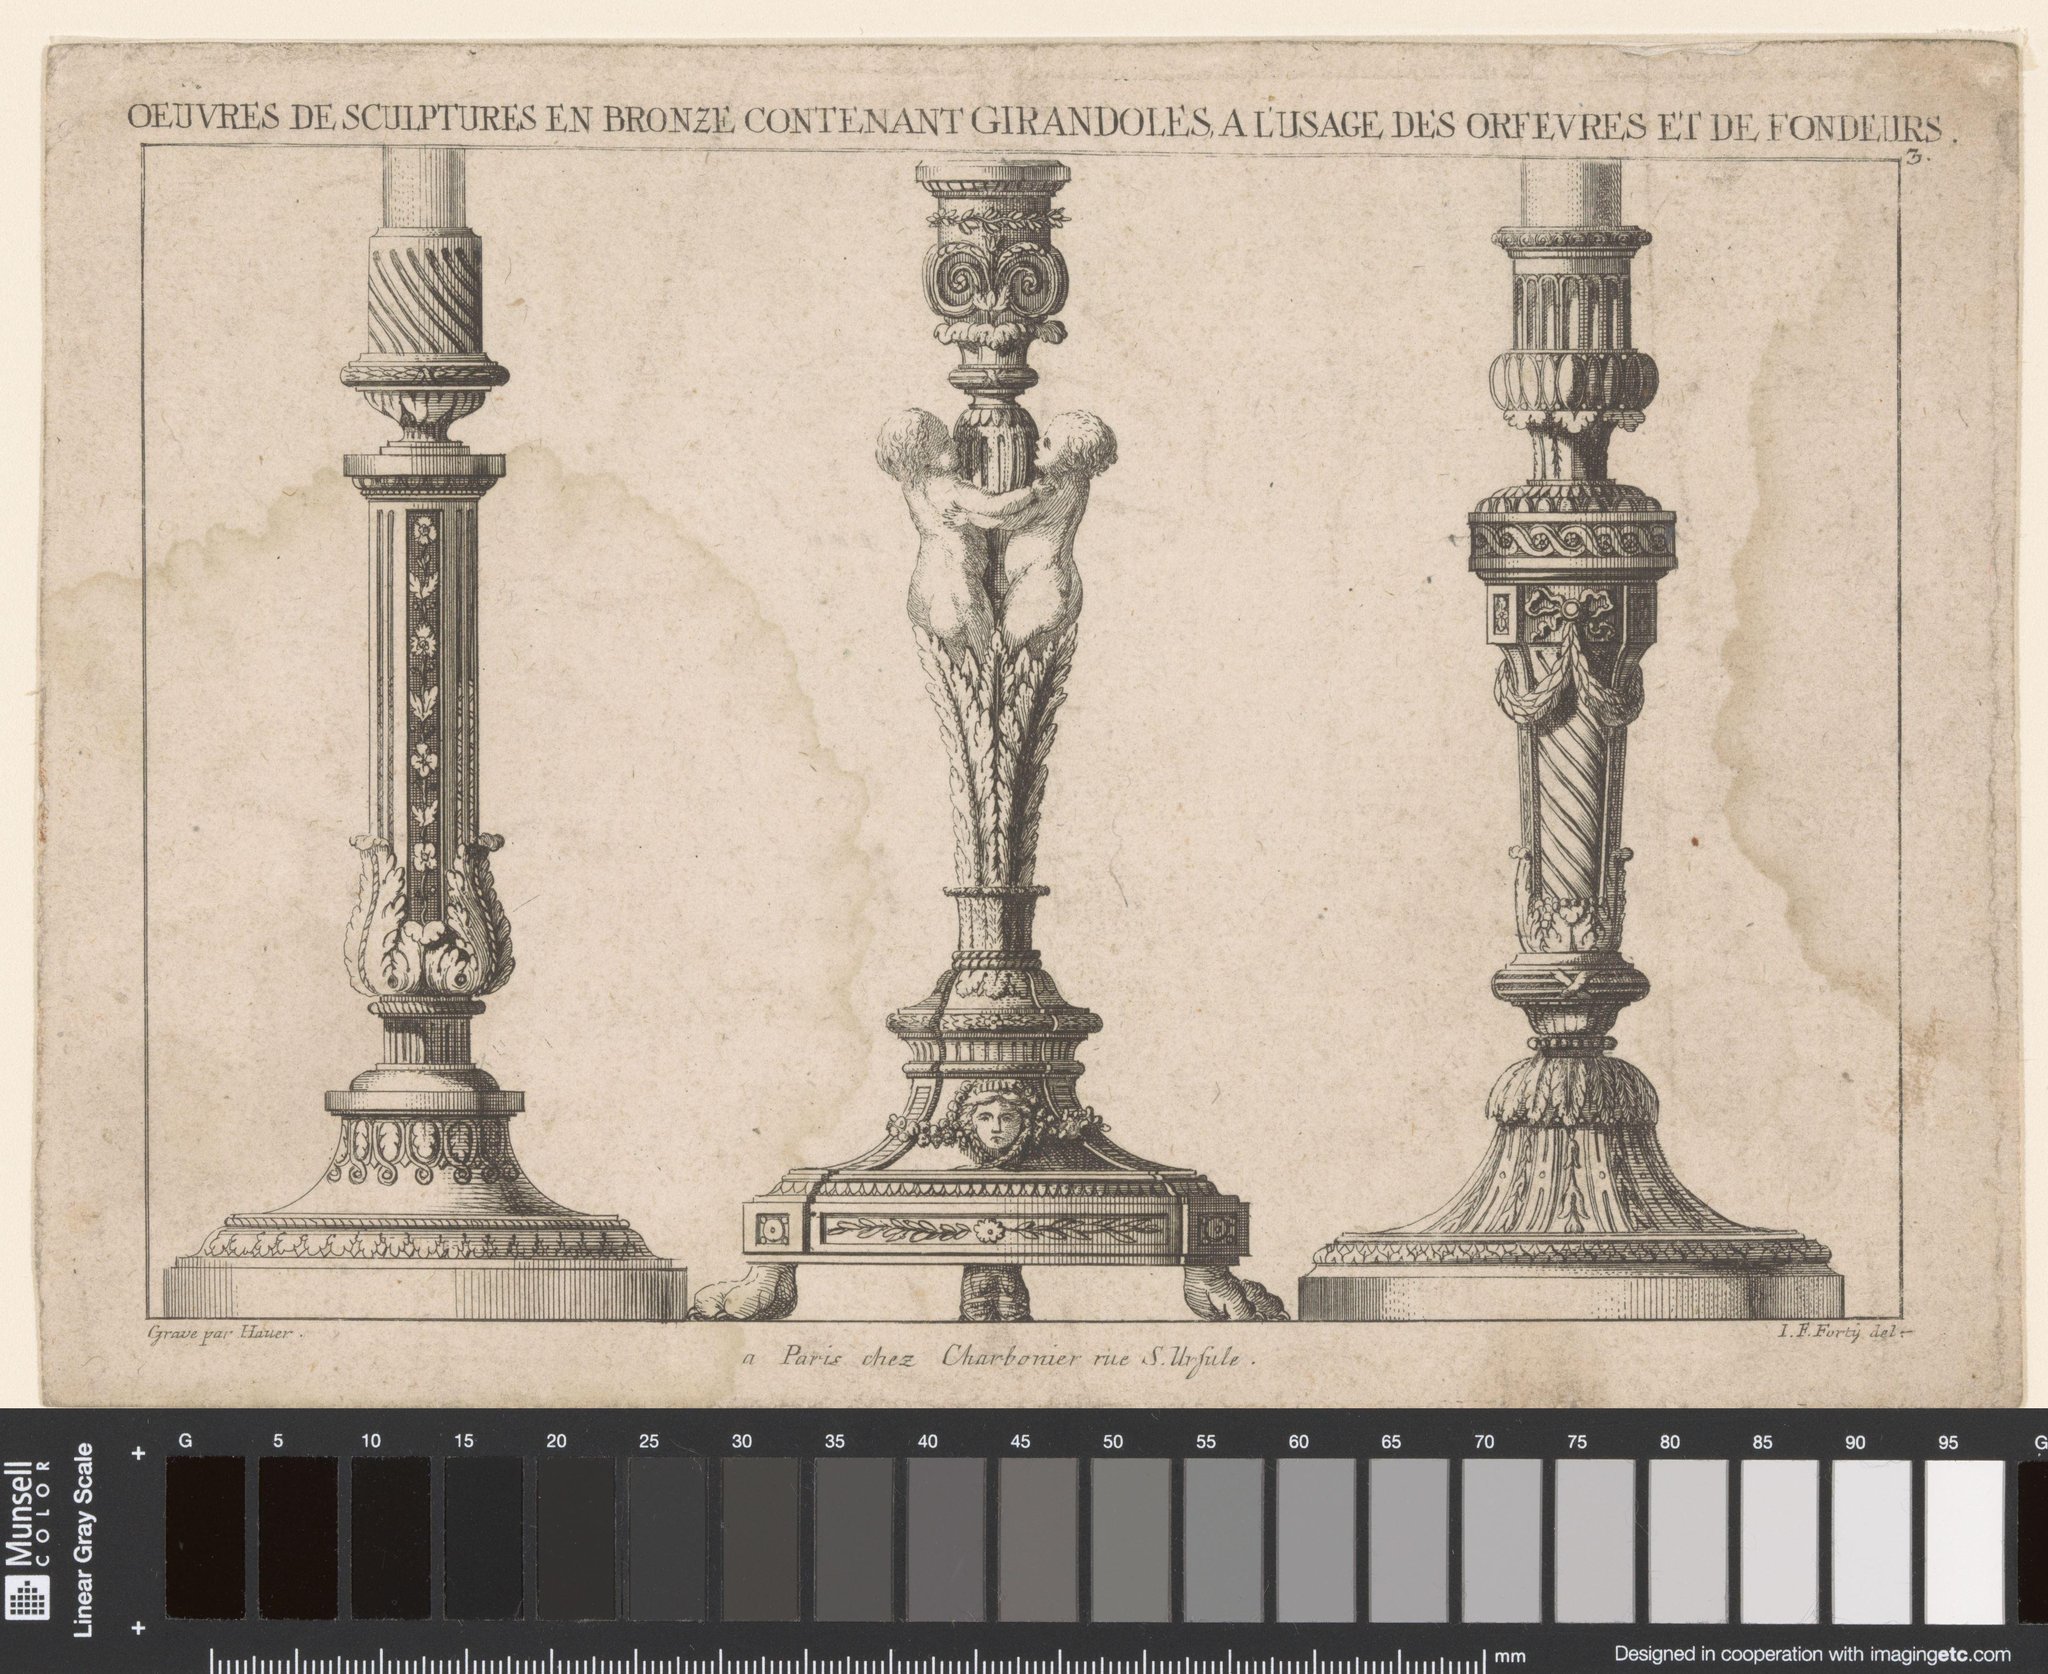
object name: ornament print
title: Drie kandelaars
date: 1775-1820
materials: paper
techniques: etching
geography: paris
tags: chandelier, candelabrum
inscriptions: collector's mark: Lugt 2760, collector's mark: Lugt 2228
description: Drie geornamenteerde kandelaars, in het midden met twee putti als halffiguren.